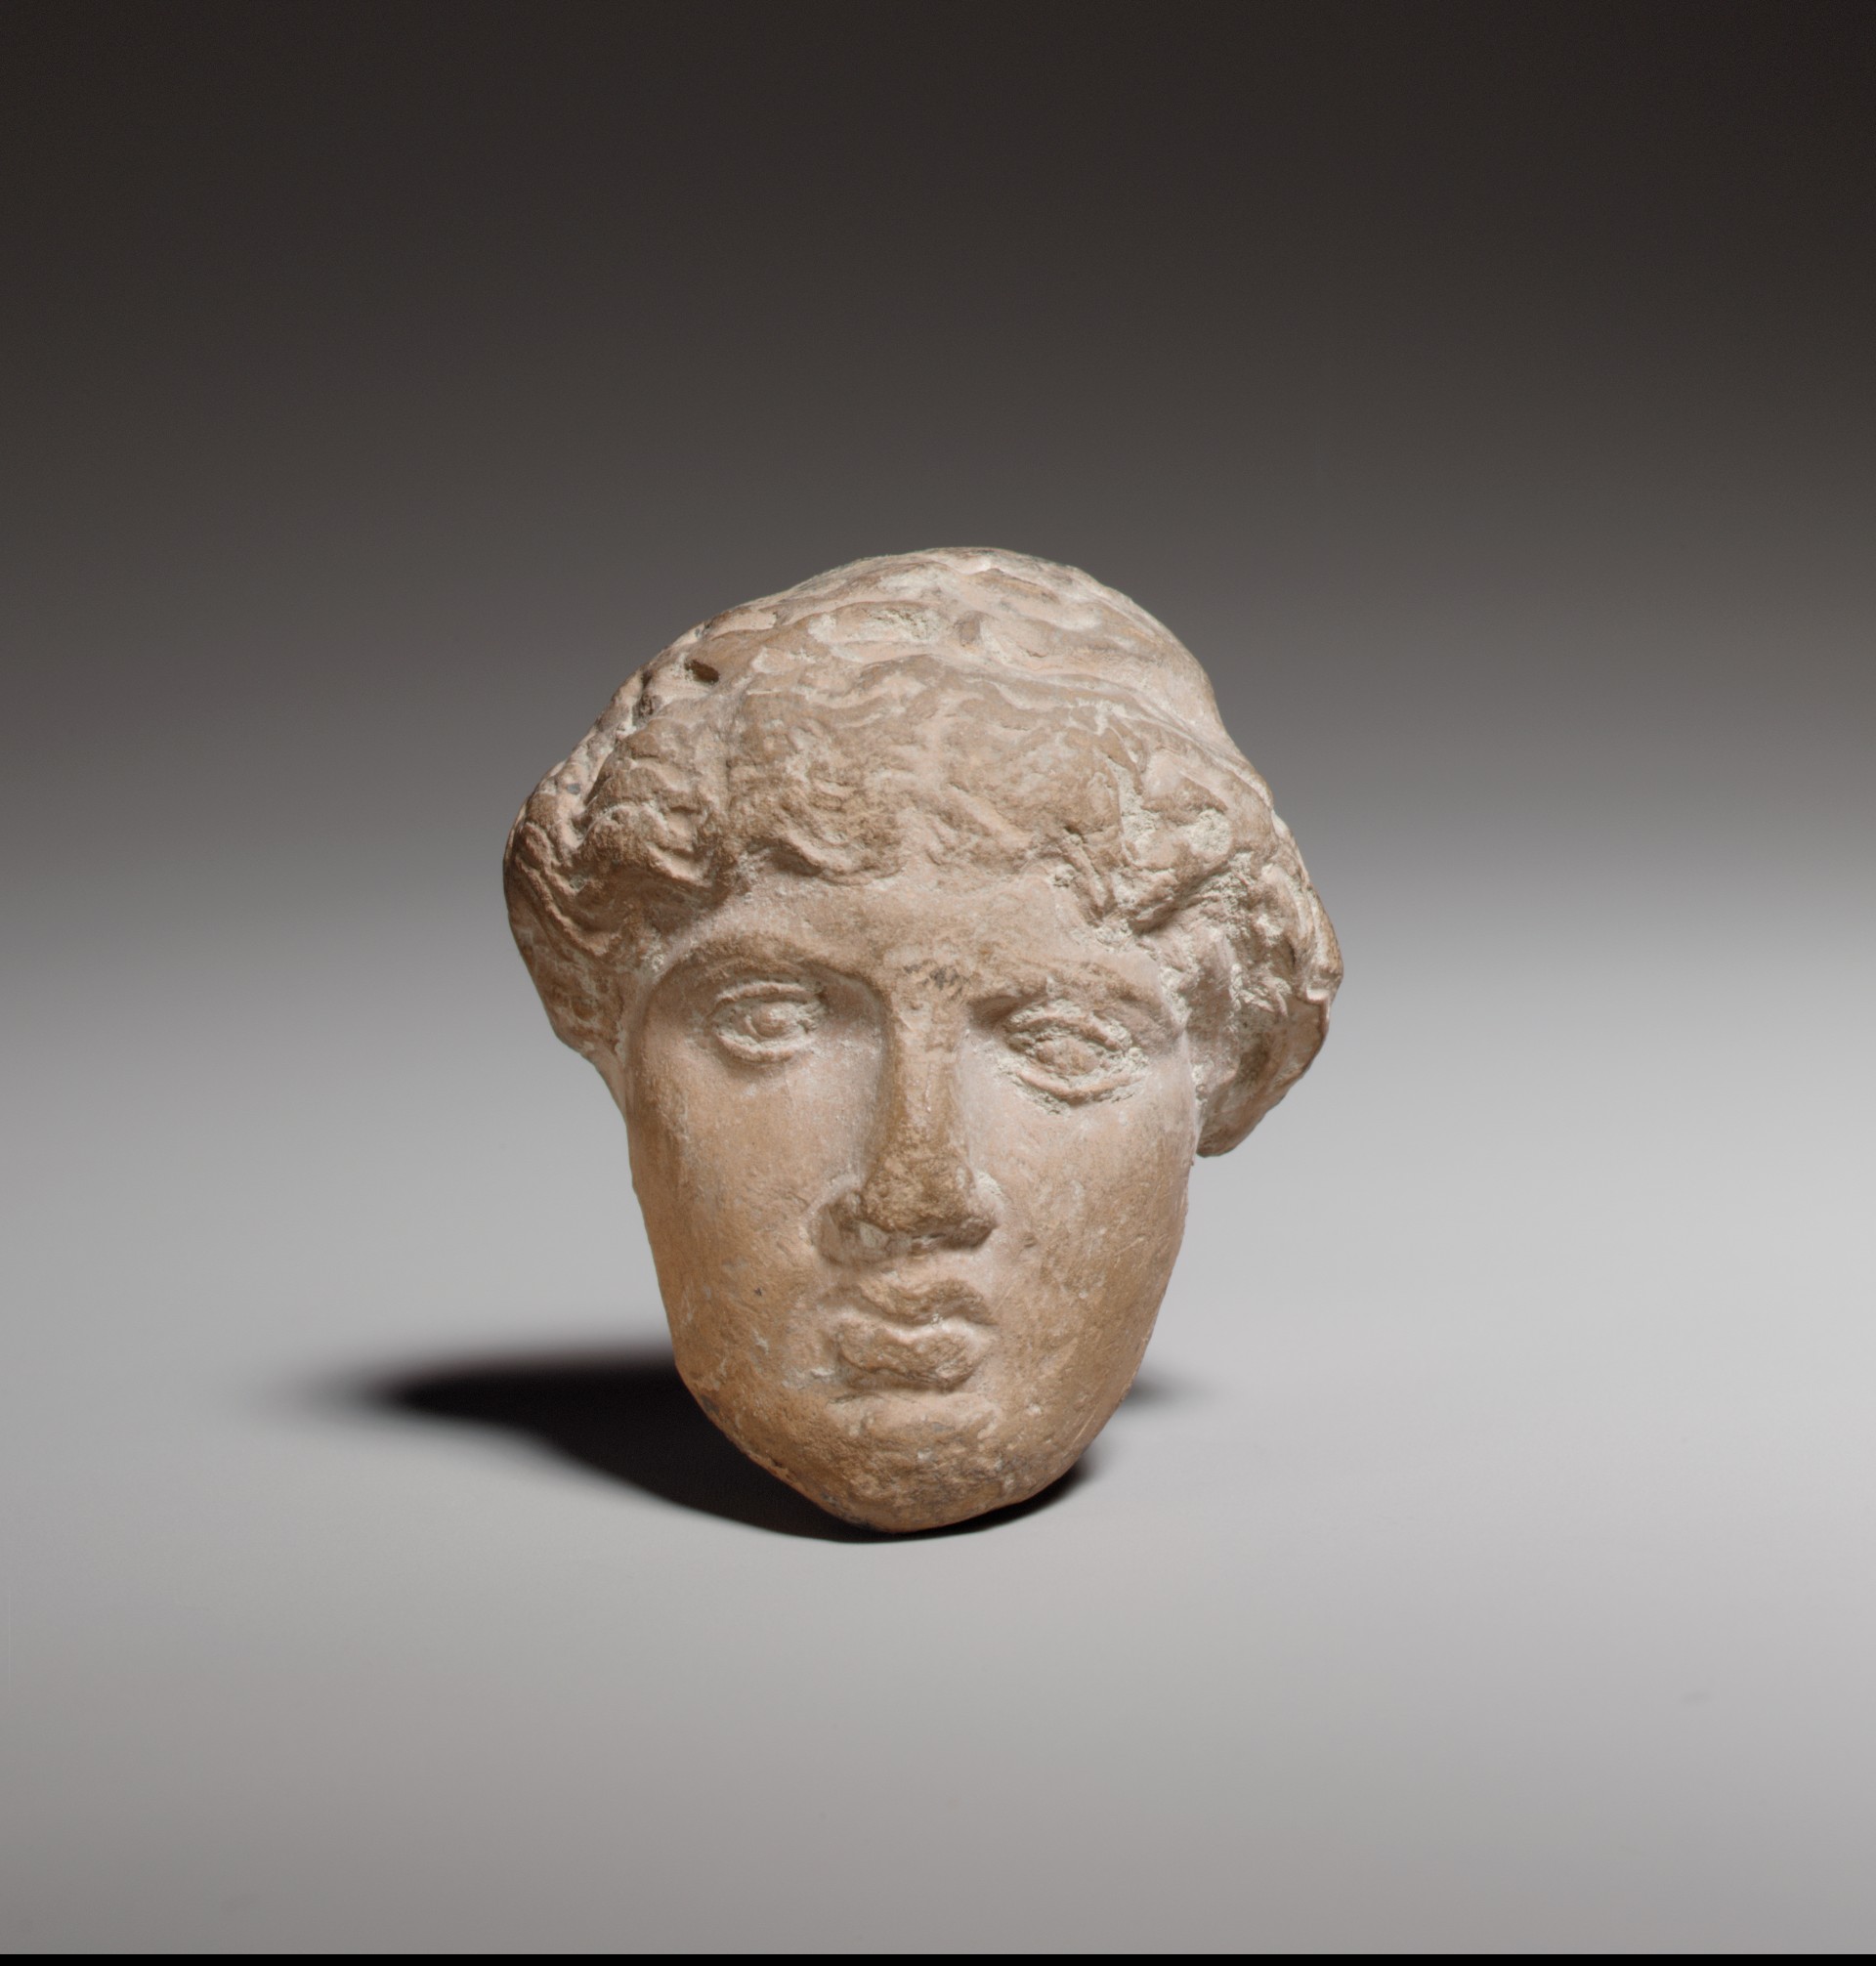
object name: head of a woman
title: Female head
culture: greek, attic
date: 467-435 BCE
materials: terracotta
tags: heads,women